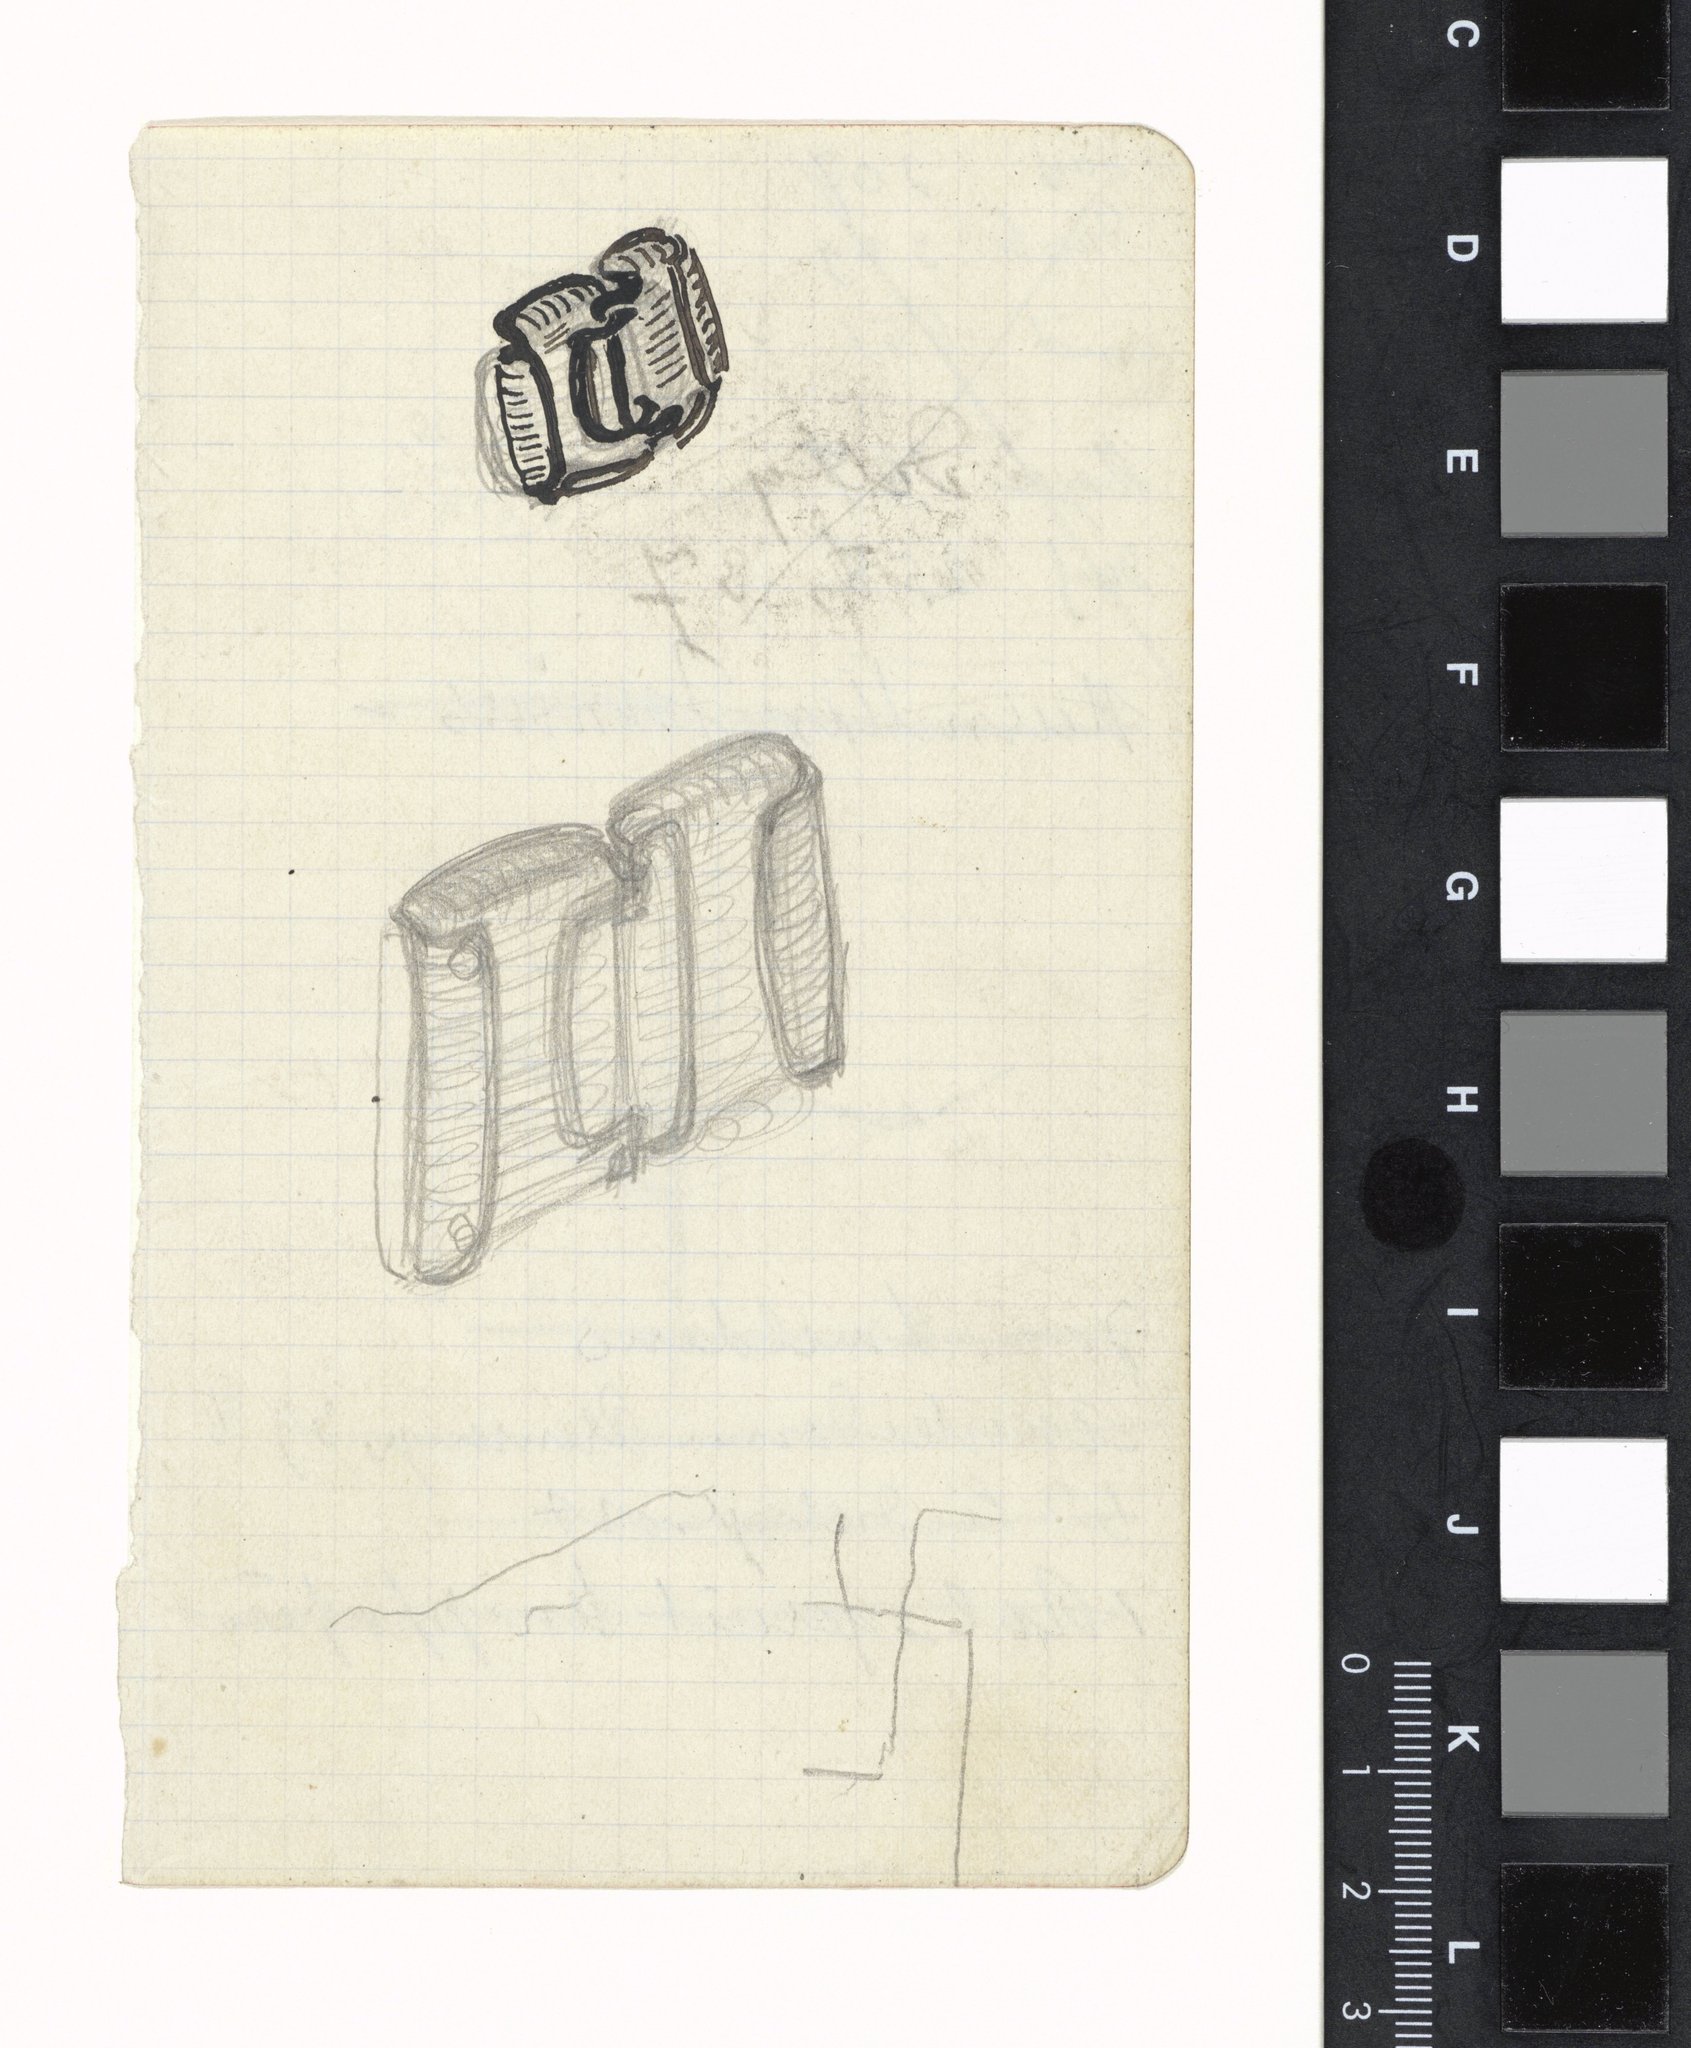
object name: design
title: Ontwerp voor een halsketting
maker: mathieu lauweriks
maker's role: designer, draughtsman, print maker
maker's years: 1864-1932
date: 1874-1932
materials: ink, pencil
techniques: pen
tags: necklace